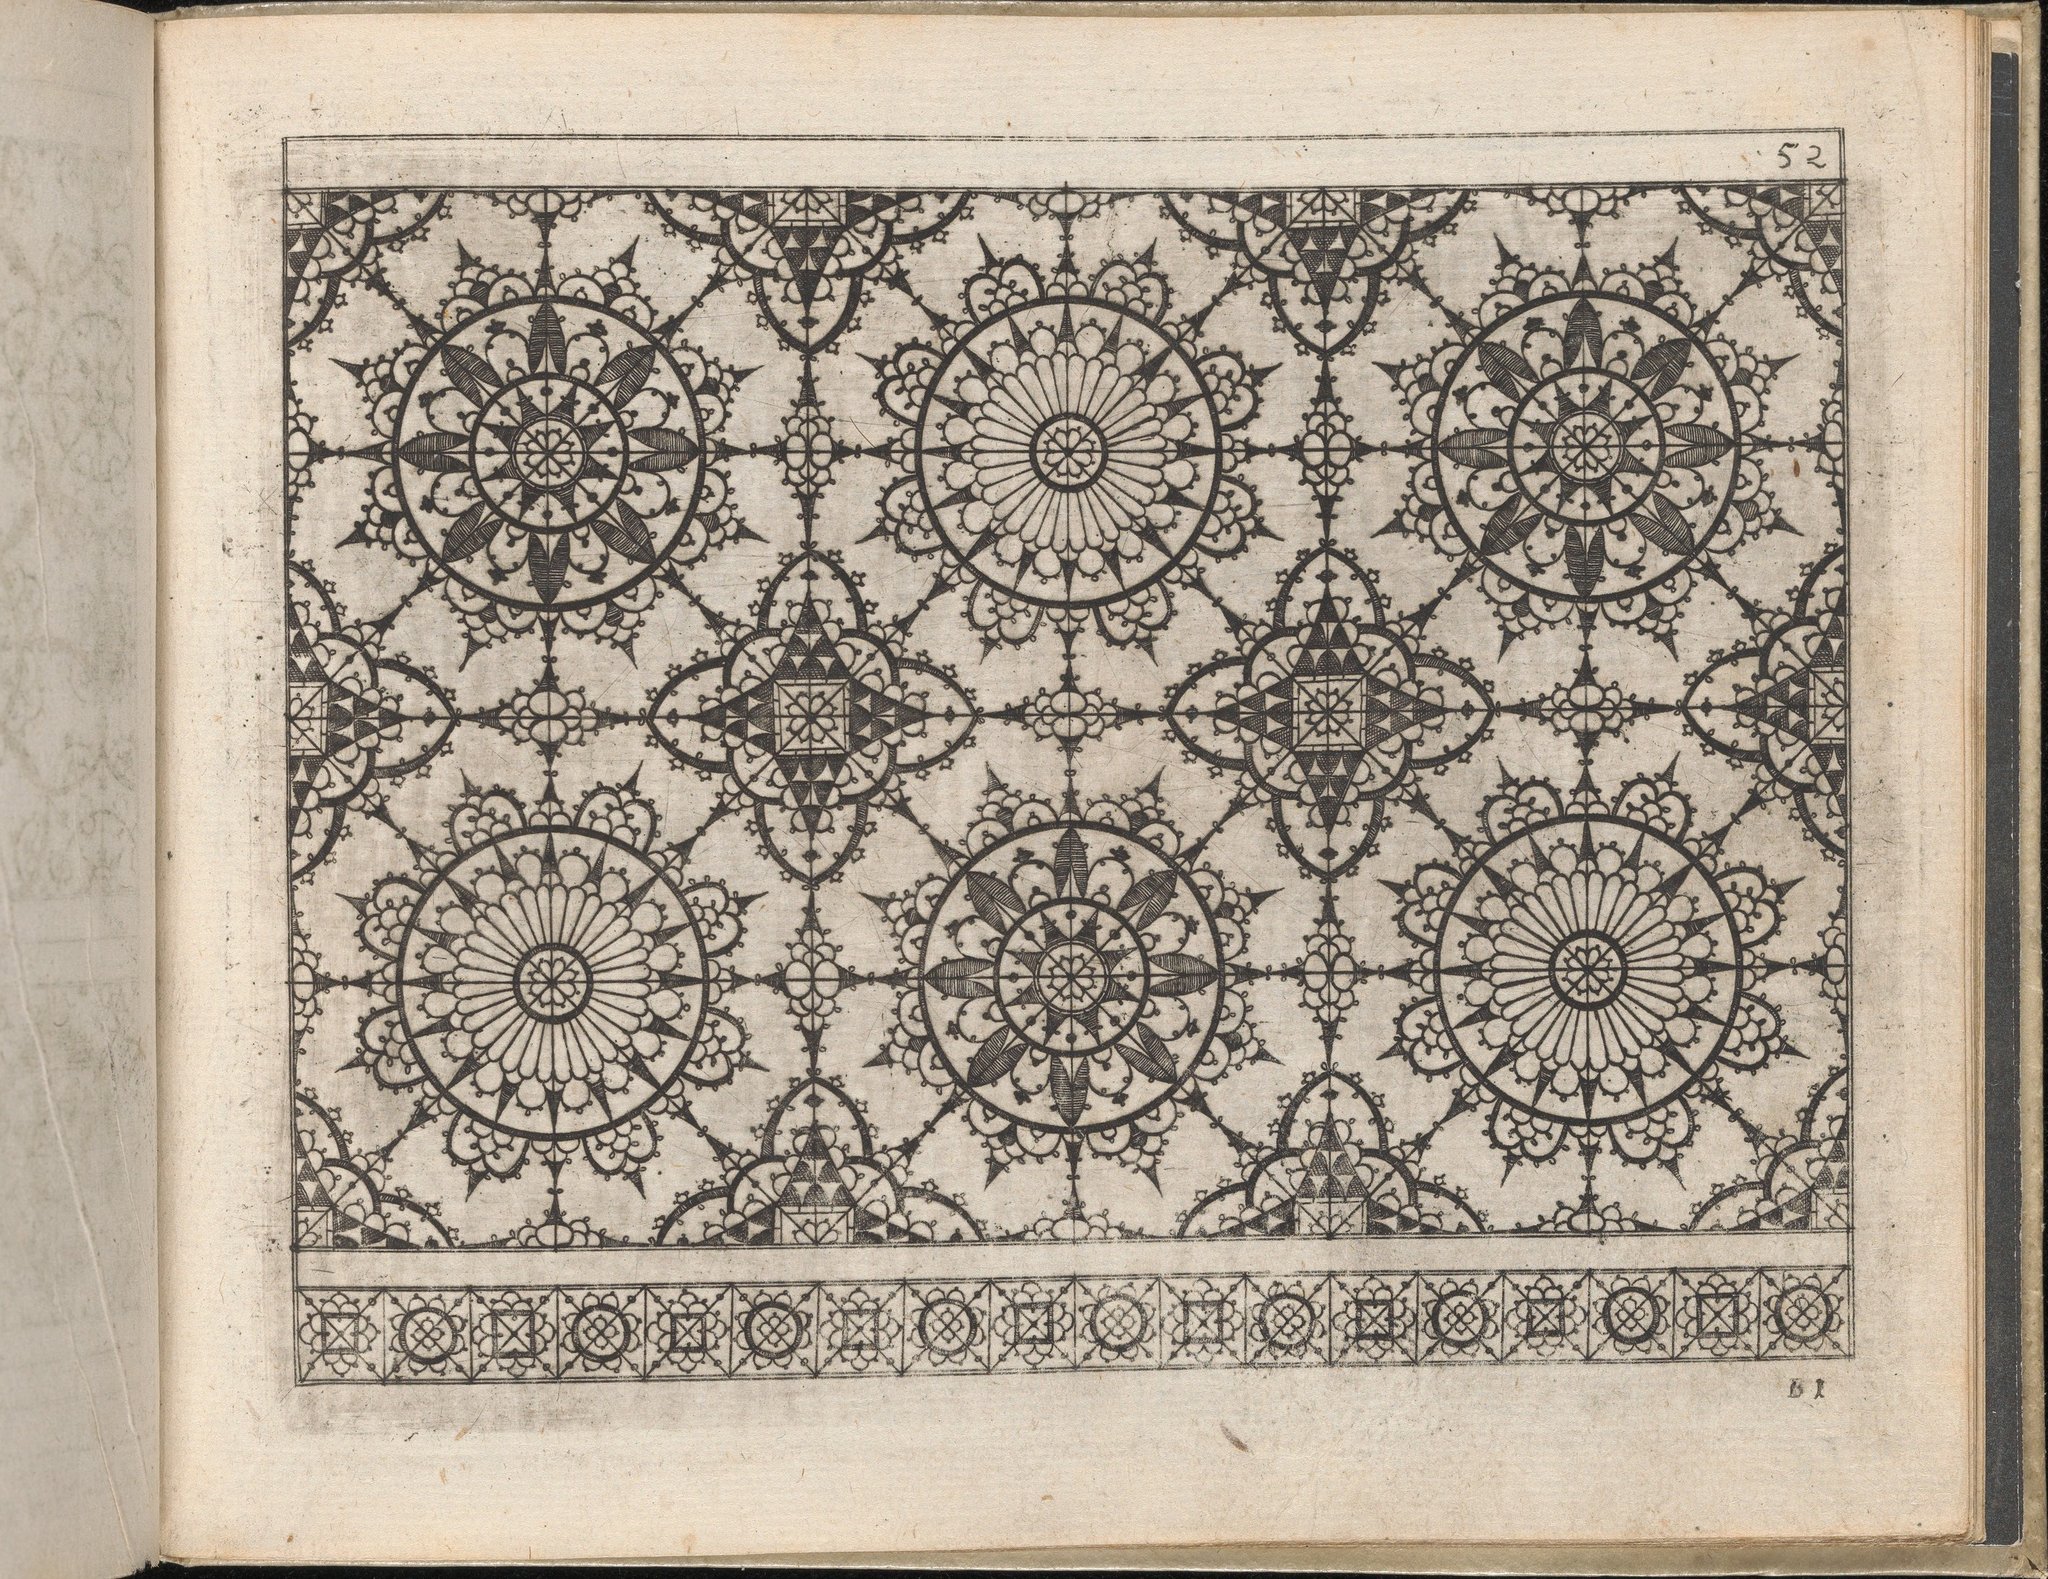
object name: book print ornament architecture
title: Newes Modelbuch in Kupffer (Page 59r)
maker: johann sibmacher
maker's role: artist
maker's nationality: german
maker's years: 1590-1611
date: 1604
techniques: etching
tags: flowers